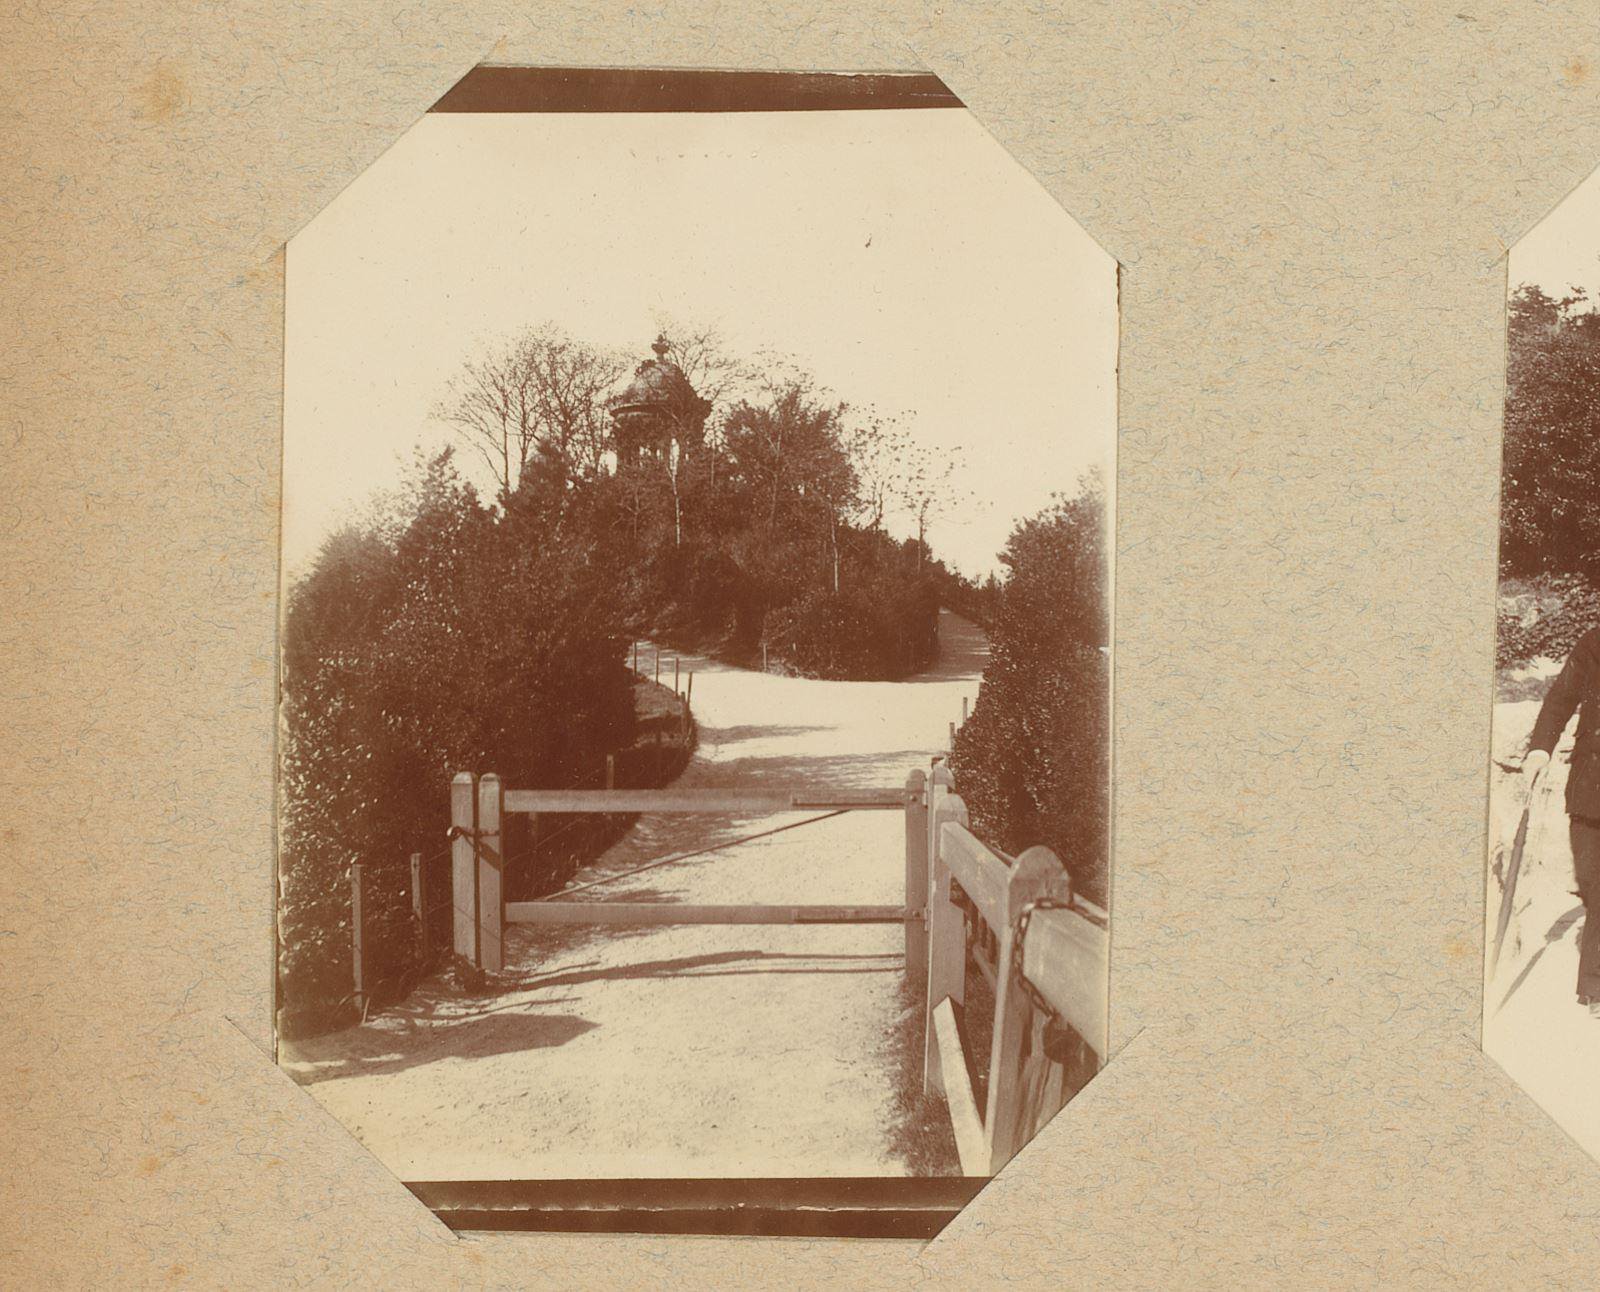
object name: album leaf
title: Park of tuin met paviljoen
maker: Anonymous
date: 1897-1900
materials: paper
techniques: gelatin silver print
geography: france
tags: public gardens, park, france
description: Over de foto is een ander negatief afgedrukt van een voorstelling van bomen.